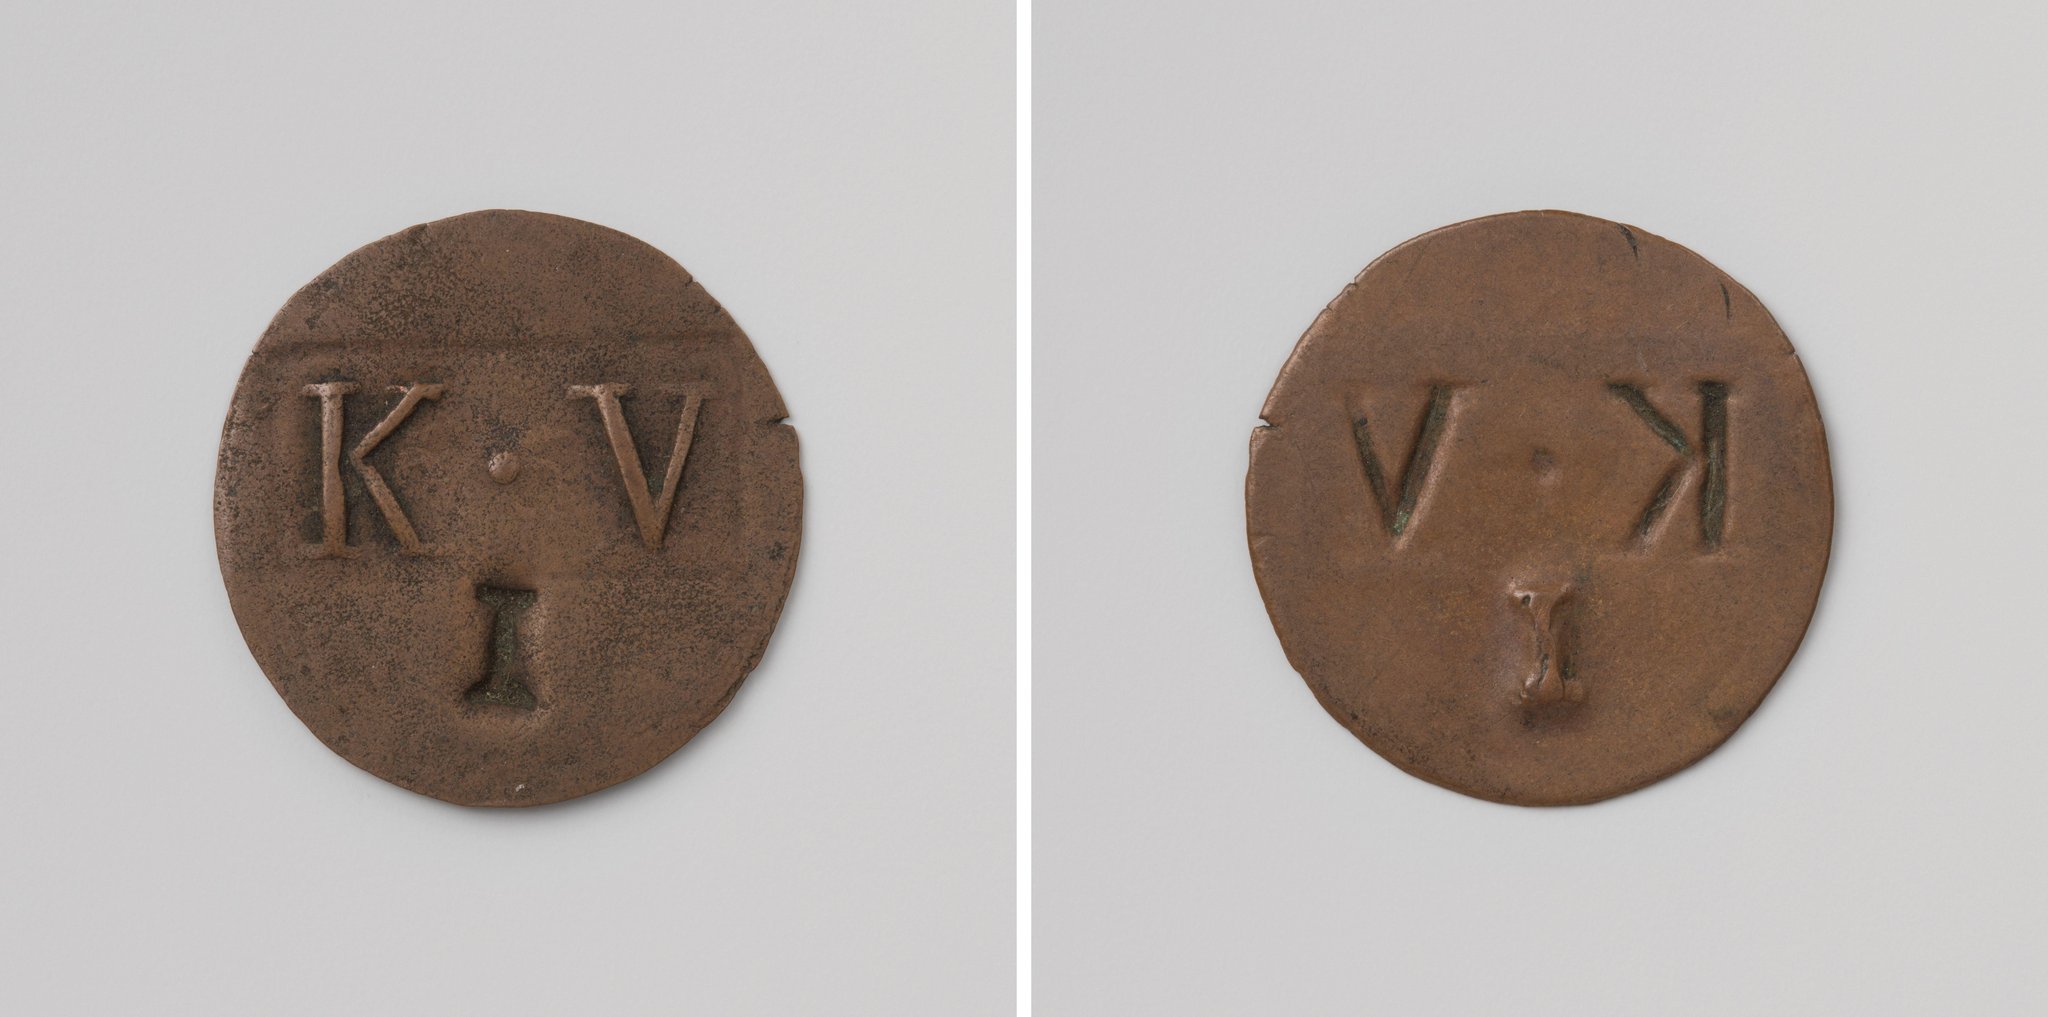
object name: cent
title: Kolonie Veenhuizen, huismunt geslagen op last van de Maatschappij van Weldadigheid ter waarde van 1 cent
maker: Anonymous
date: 1818-1859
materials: copper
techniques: striking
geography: netherlands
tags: maatschappij van weldadigheid, veenhuizen